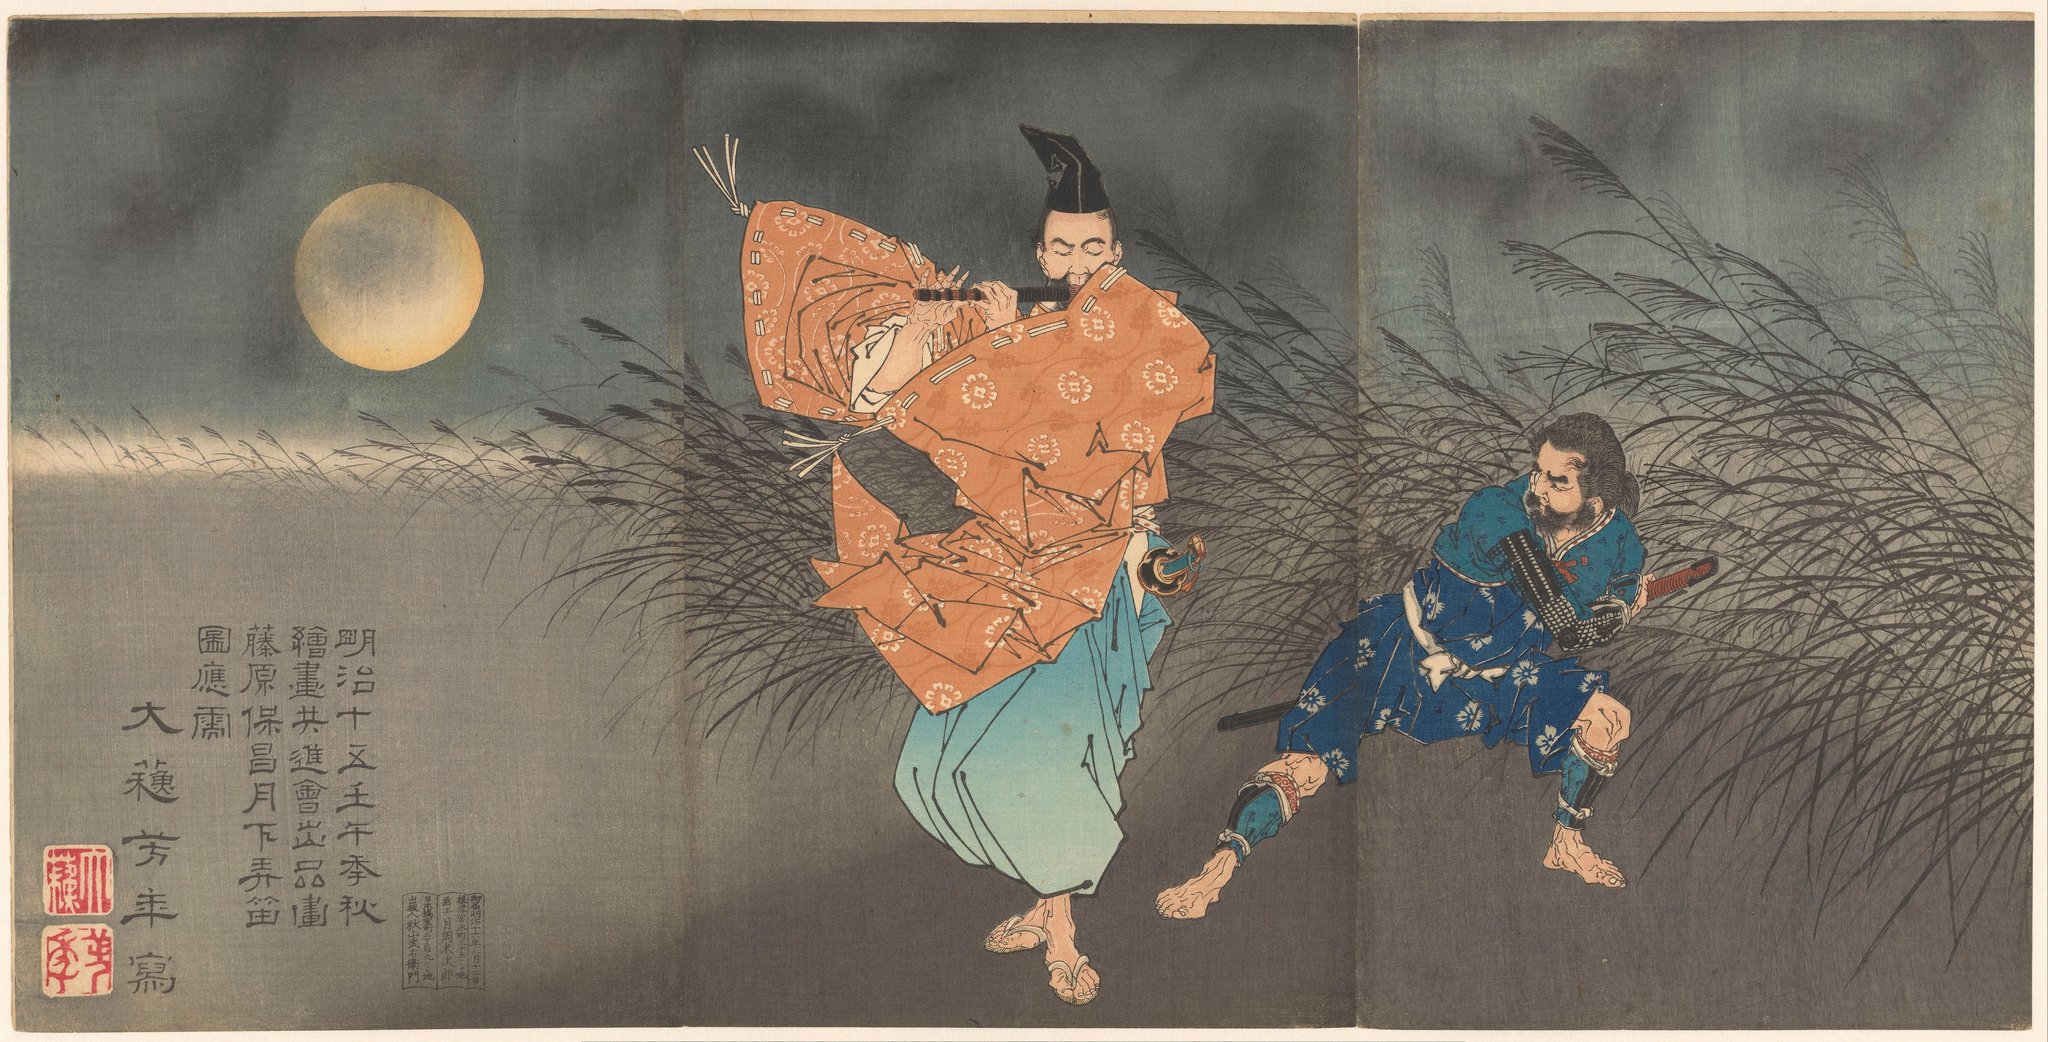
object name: print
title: Fluitspeler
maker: tsukioka yoshitoshi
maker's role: print maker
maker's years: 1839-1892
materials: paper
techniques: woodcut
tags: one person playing wind instrument, flute, aulos, tibia